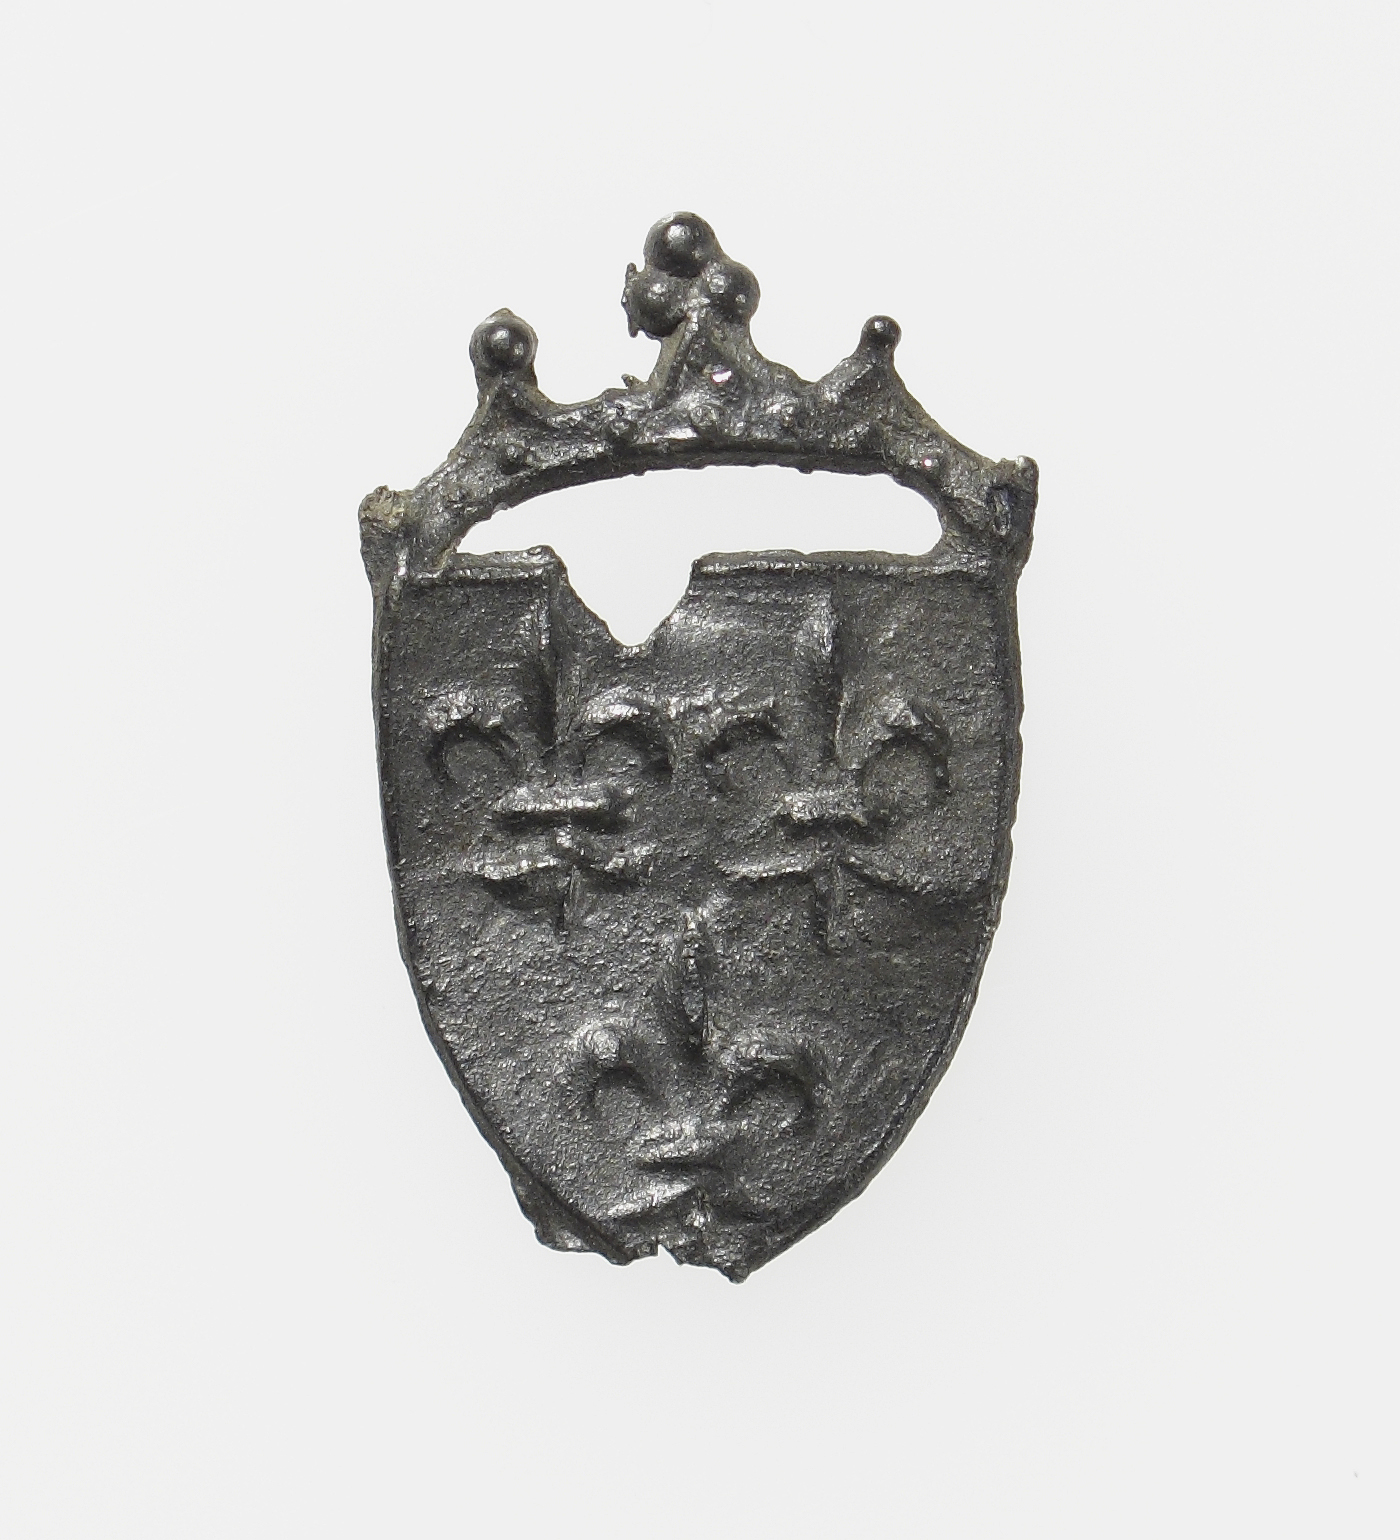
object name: pilgrim's badge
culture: french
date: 1301-1600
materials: lead